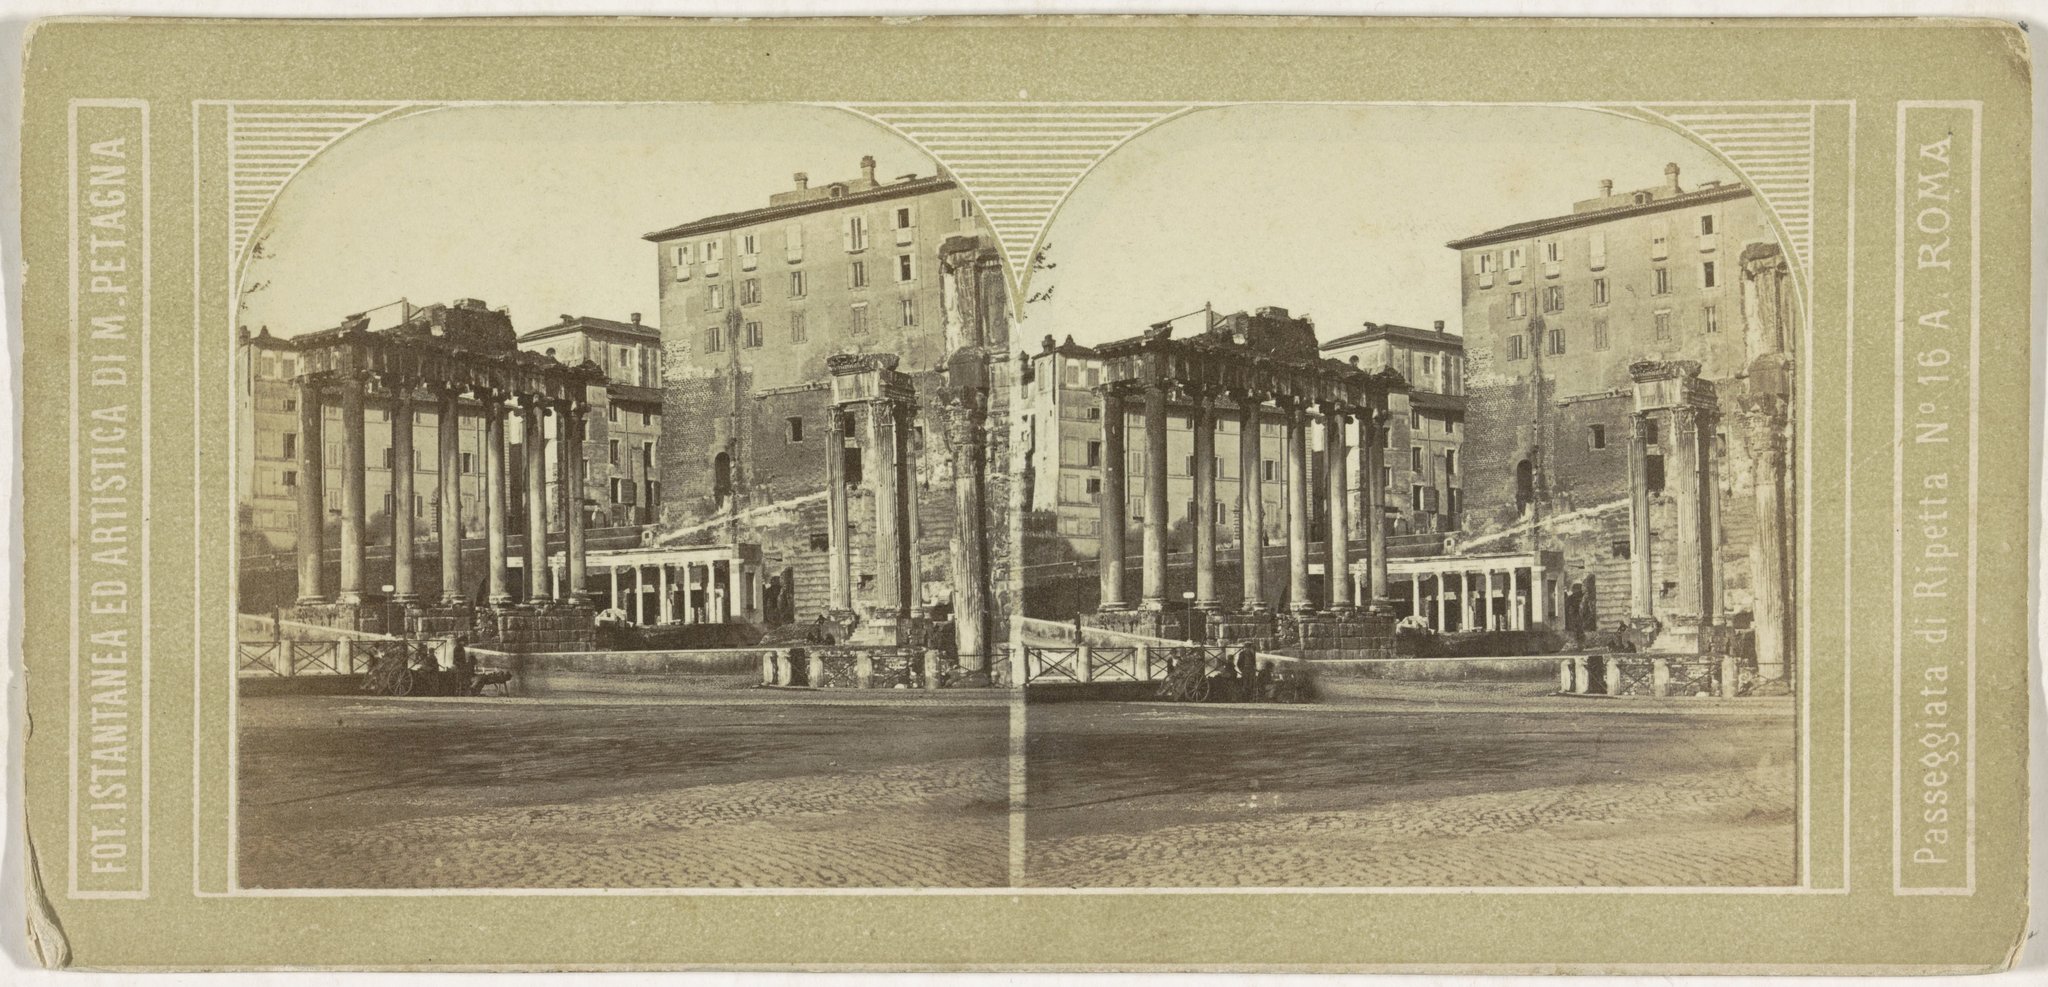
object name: stereograph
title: Gezicht op het Capitool met ruïnes van het Forum Romanum, Rome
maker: m. petagna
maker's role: fotograaf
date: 1865-1920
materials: cardboard, paper, photographic support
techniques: albumen print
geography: italy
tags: forum romanum, capitool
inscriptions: inscription: ‘15 €’, annotation: ‘Vue de Capitale Forum.’, annotation: ‘Vue du Capitole e di (?) Forum’, annotation: ‘Vers 1865’